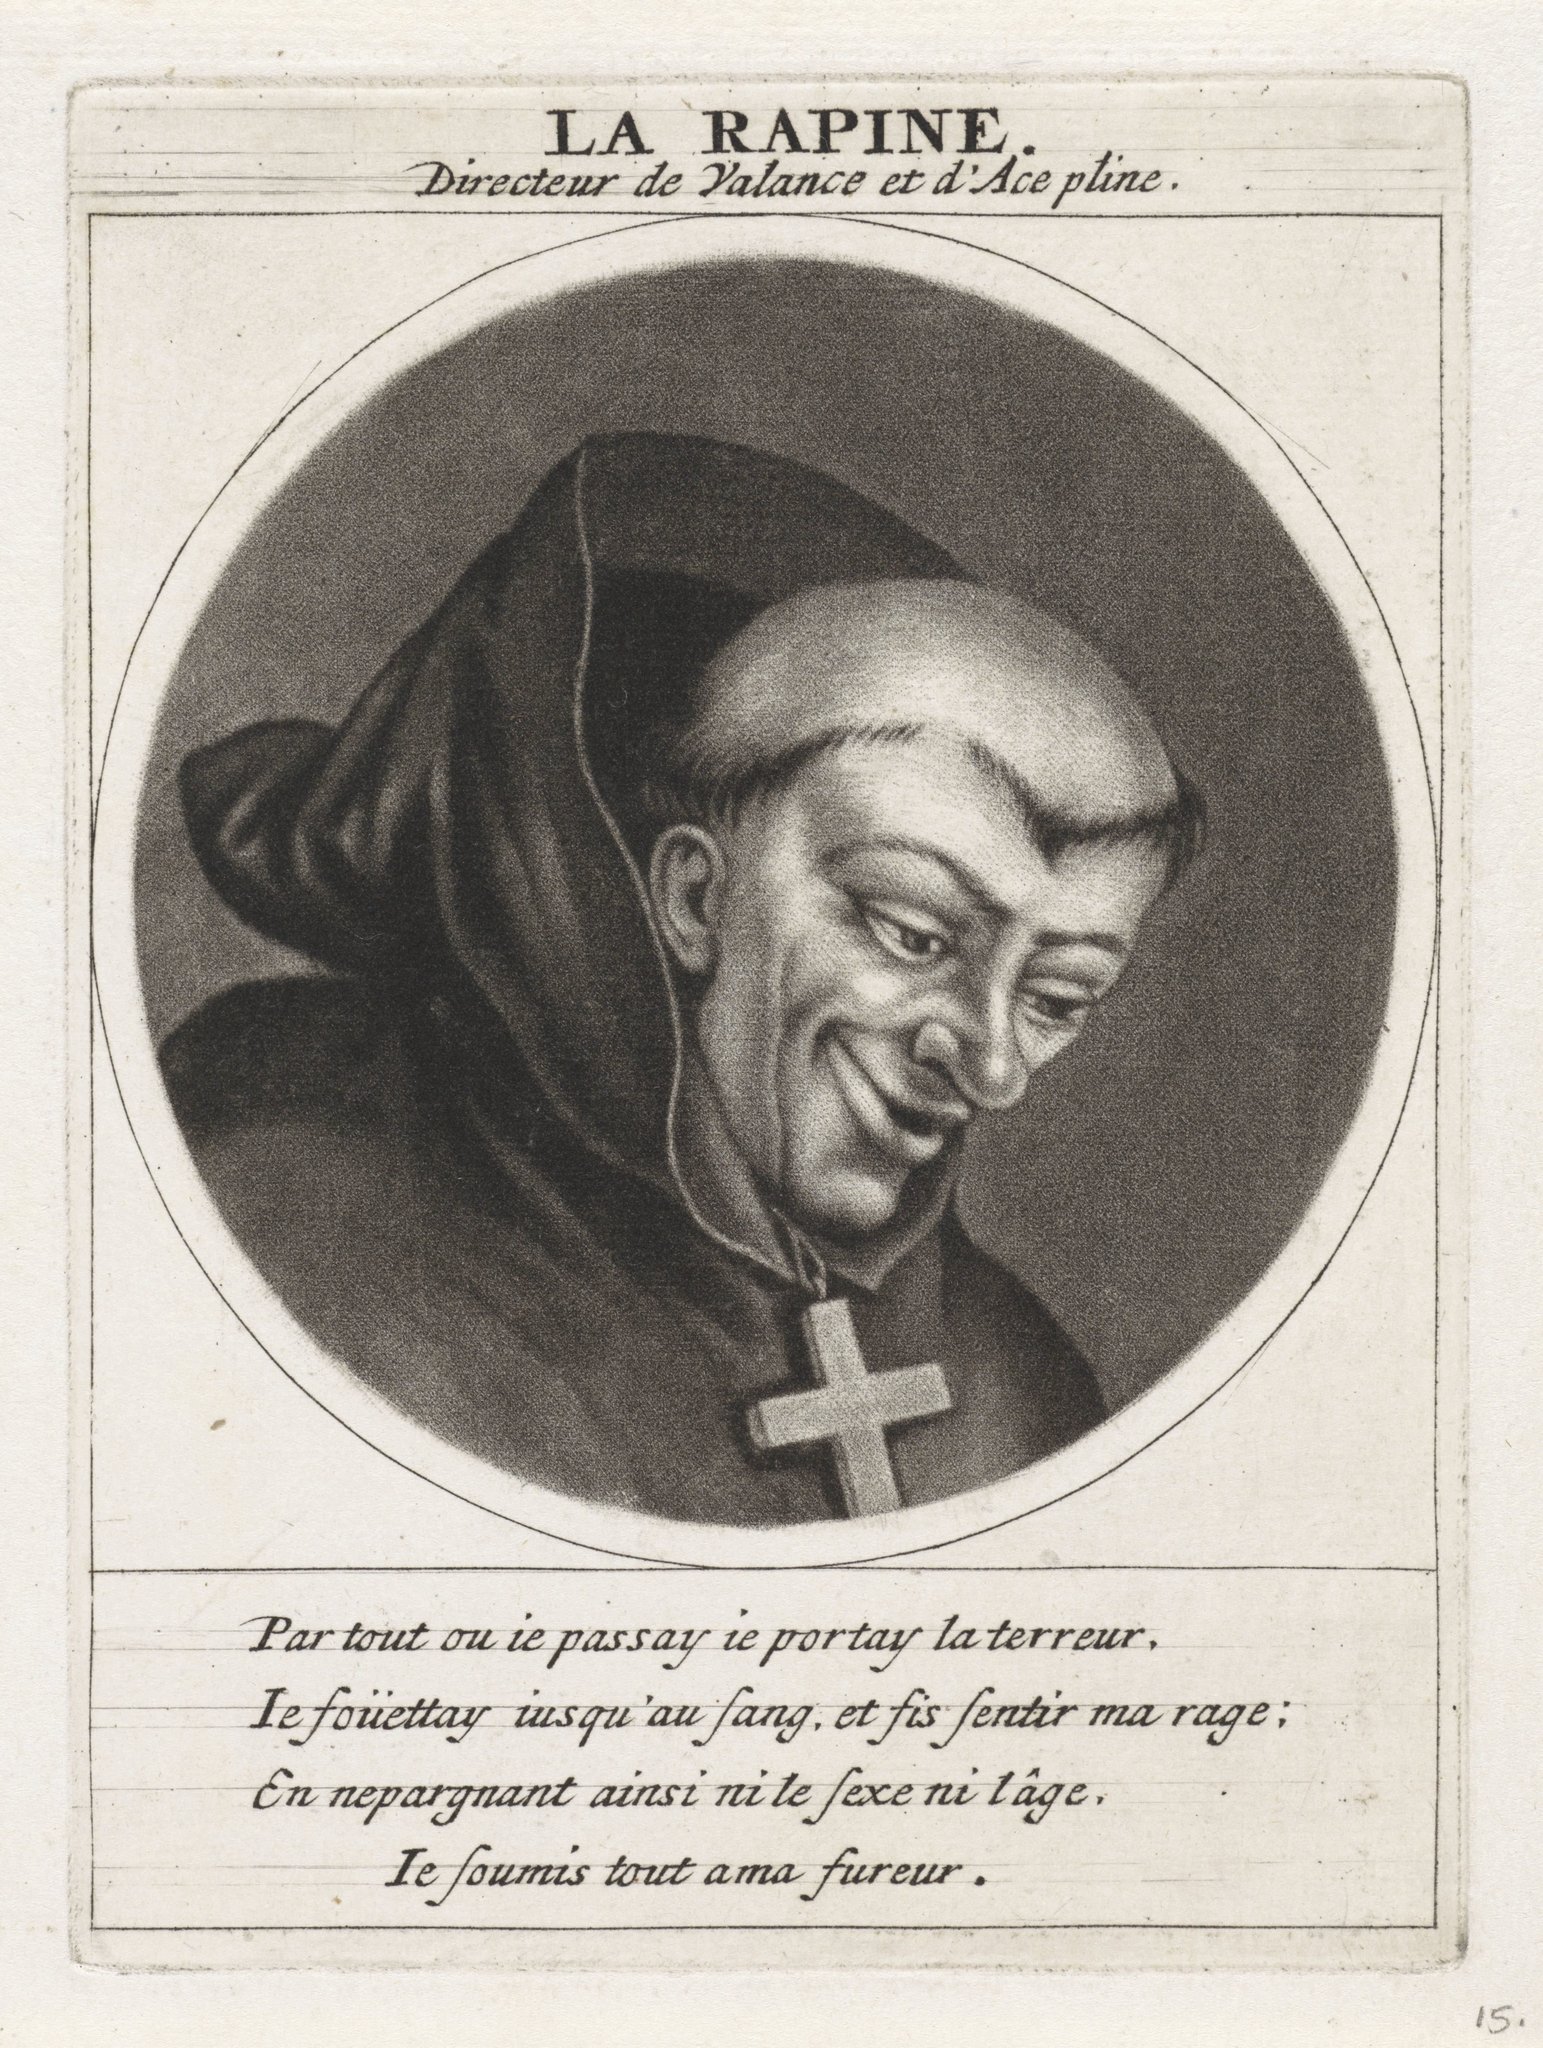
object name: print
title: La Rapine, directeur de Valance et d'Ace pline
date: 1691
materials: paper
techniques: engraving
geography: paris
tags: the cross ~ symbols of christ, political caricatures and satires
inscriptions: collector's mark: Lugt 240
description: Titelpagina voor: Les Heros de la Ligue: ou la procession monacale, conduitte par Louis XIV, pour la conversion des Protestants de son royaume. Chez. Pere Peters en Louis le Grand: Parijs, 1691. (De uitgevers zijn fictief.)